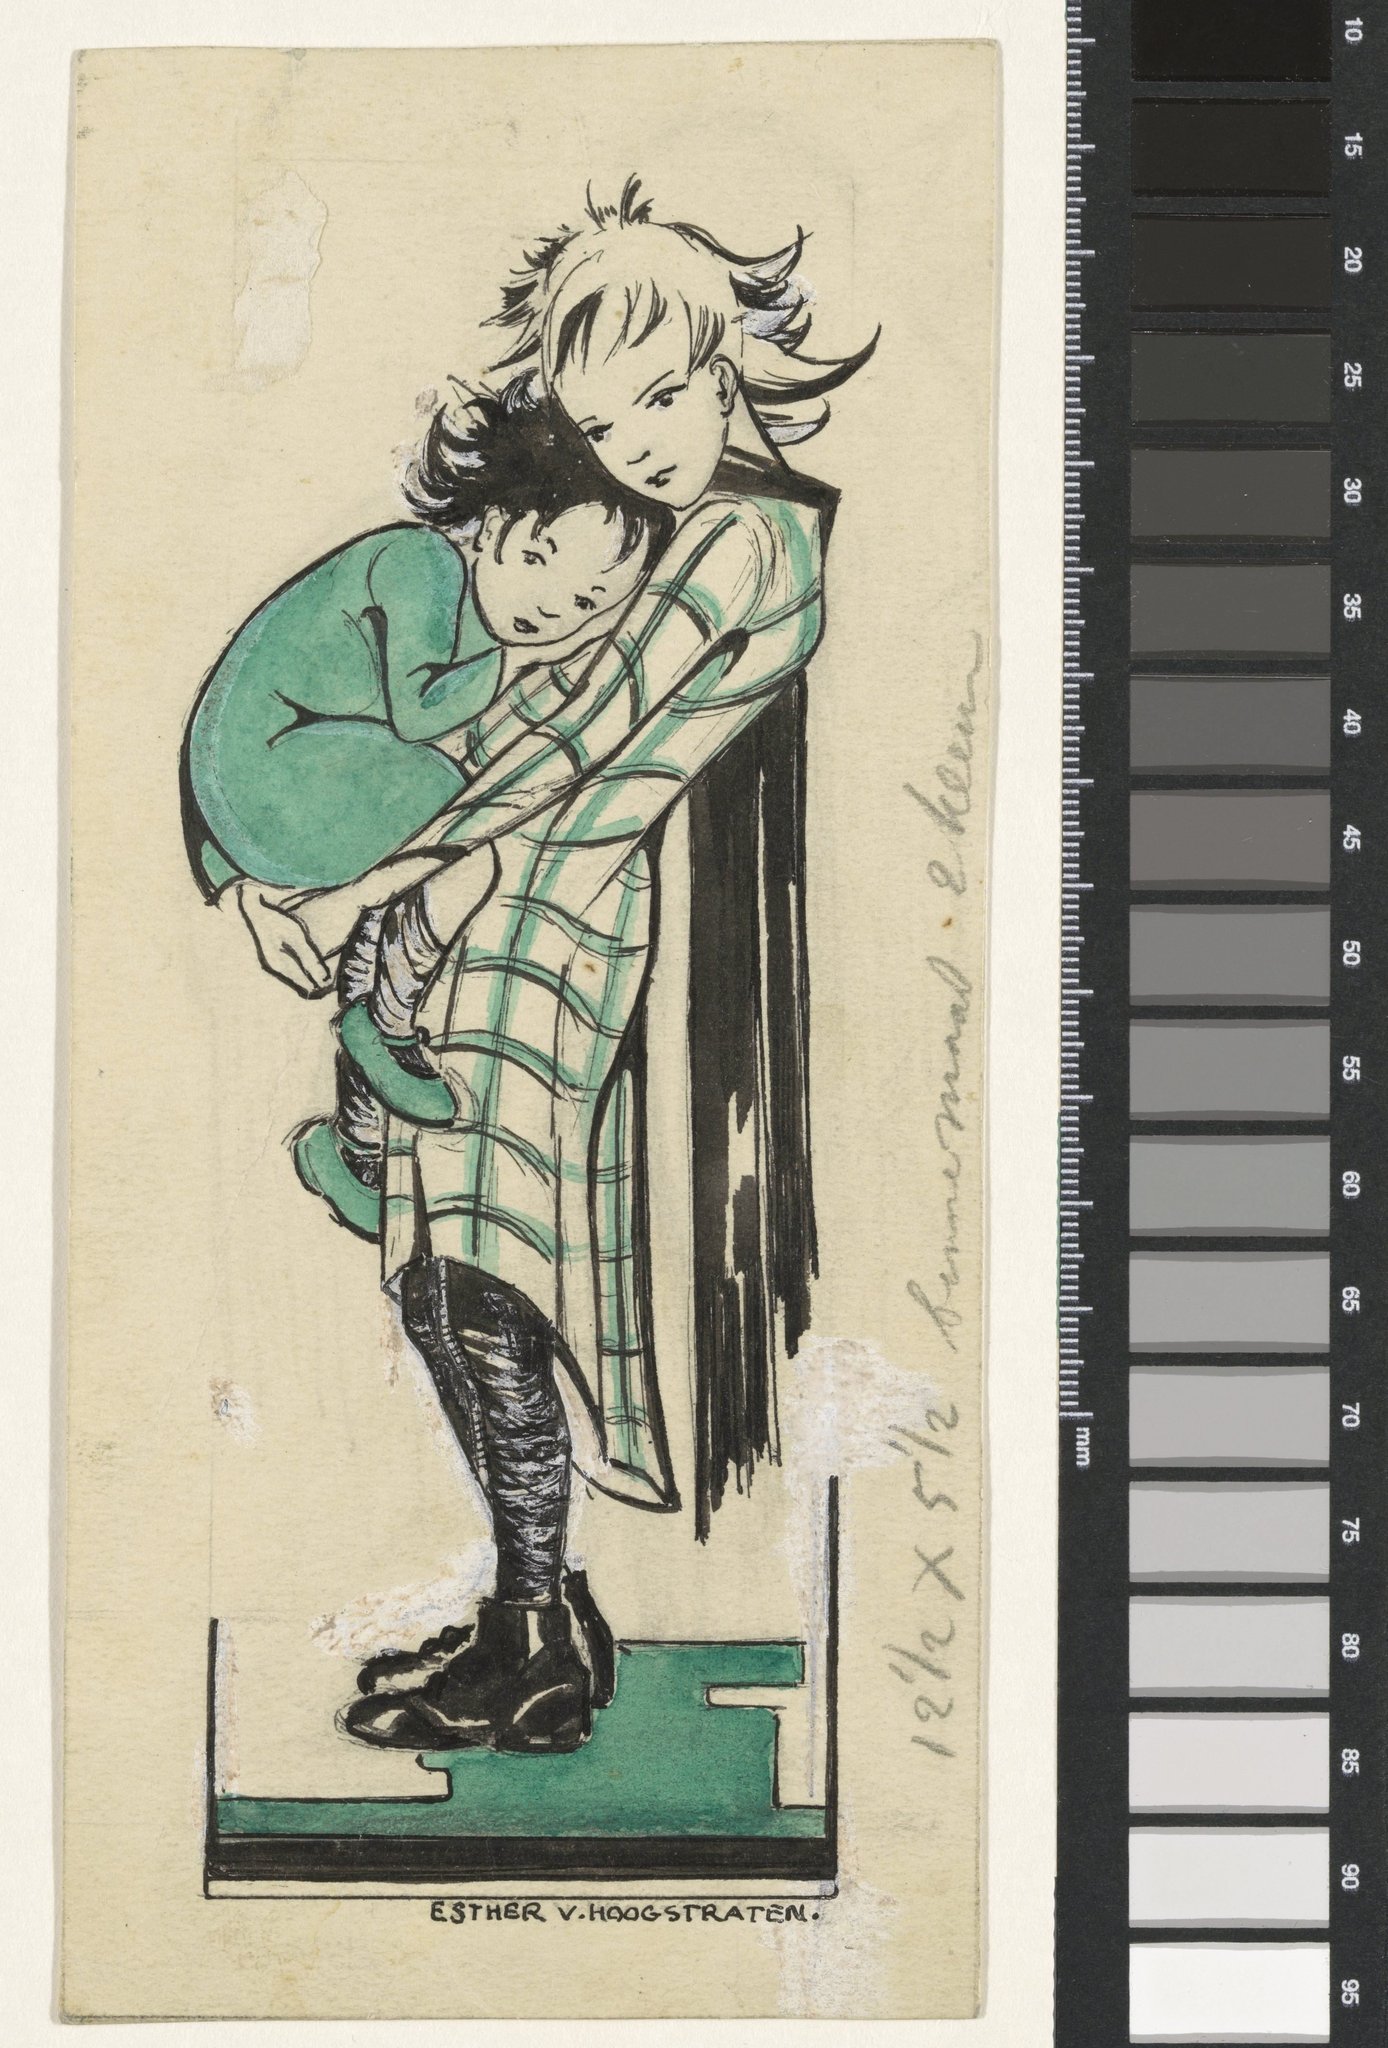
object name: boekillustratie ontwerp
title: Meisje met kind op de arm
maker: esther van hoogstraten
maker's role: draughtsman, print maker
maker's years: 1907-1995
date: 1920-1935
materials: paint, ink, paper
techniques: brush, pen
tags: girl (child between toddler and youth), other methods of carrying children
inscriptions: :, collector's mark: Lugt 2228, address: ‘Mr. G. T. J. DE JONGH/ AMSTERDAM/ Van Miereveldstraat 9.’, annotation: ‘Herne/ N[...]d/ van Haaff-v. Hoog[...]/ Merellaan Velzen’, signature: ‘ESTHER V. HOOGSTRATEN.’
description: Een meisje in een jurk draagt een jonger meisje op de arm.